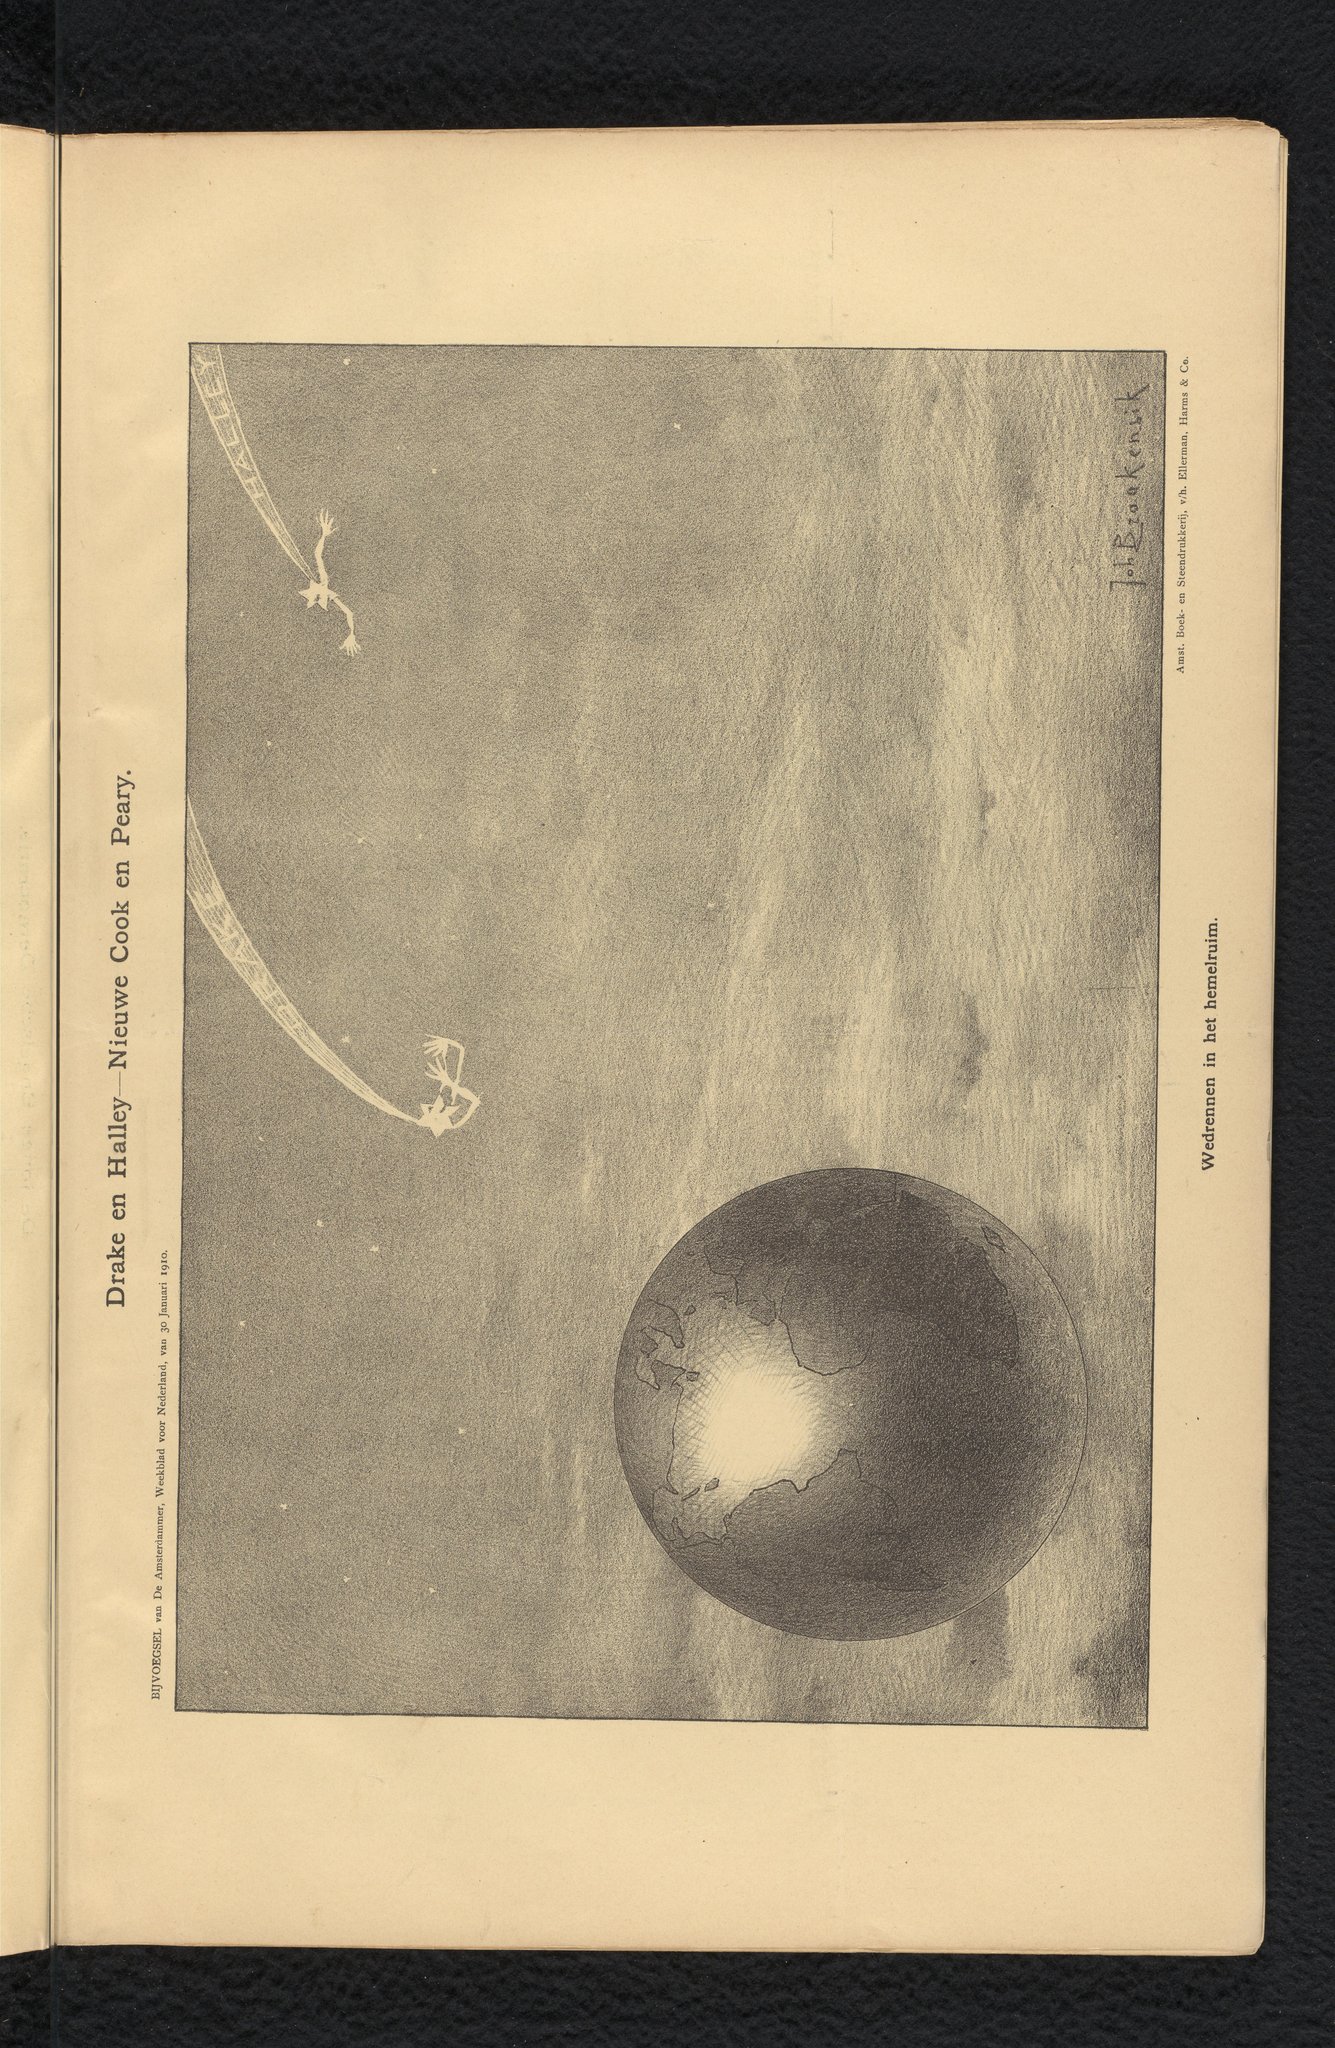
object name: cartoon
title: Drake en Halley - Nieuwe Cook en Peary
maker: johan braakensiek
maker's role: draughtsman, print maker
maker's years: 1858-1940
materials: paper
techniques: lithograph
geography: amsterdam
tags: comet, political caricatures and satires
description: Twee kometen, de Johannesburg-komeet (Drake) en de komeet van Halley, in een wedstrijd aan de hemel boven de wereldbol in 1910.